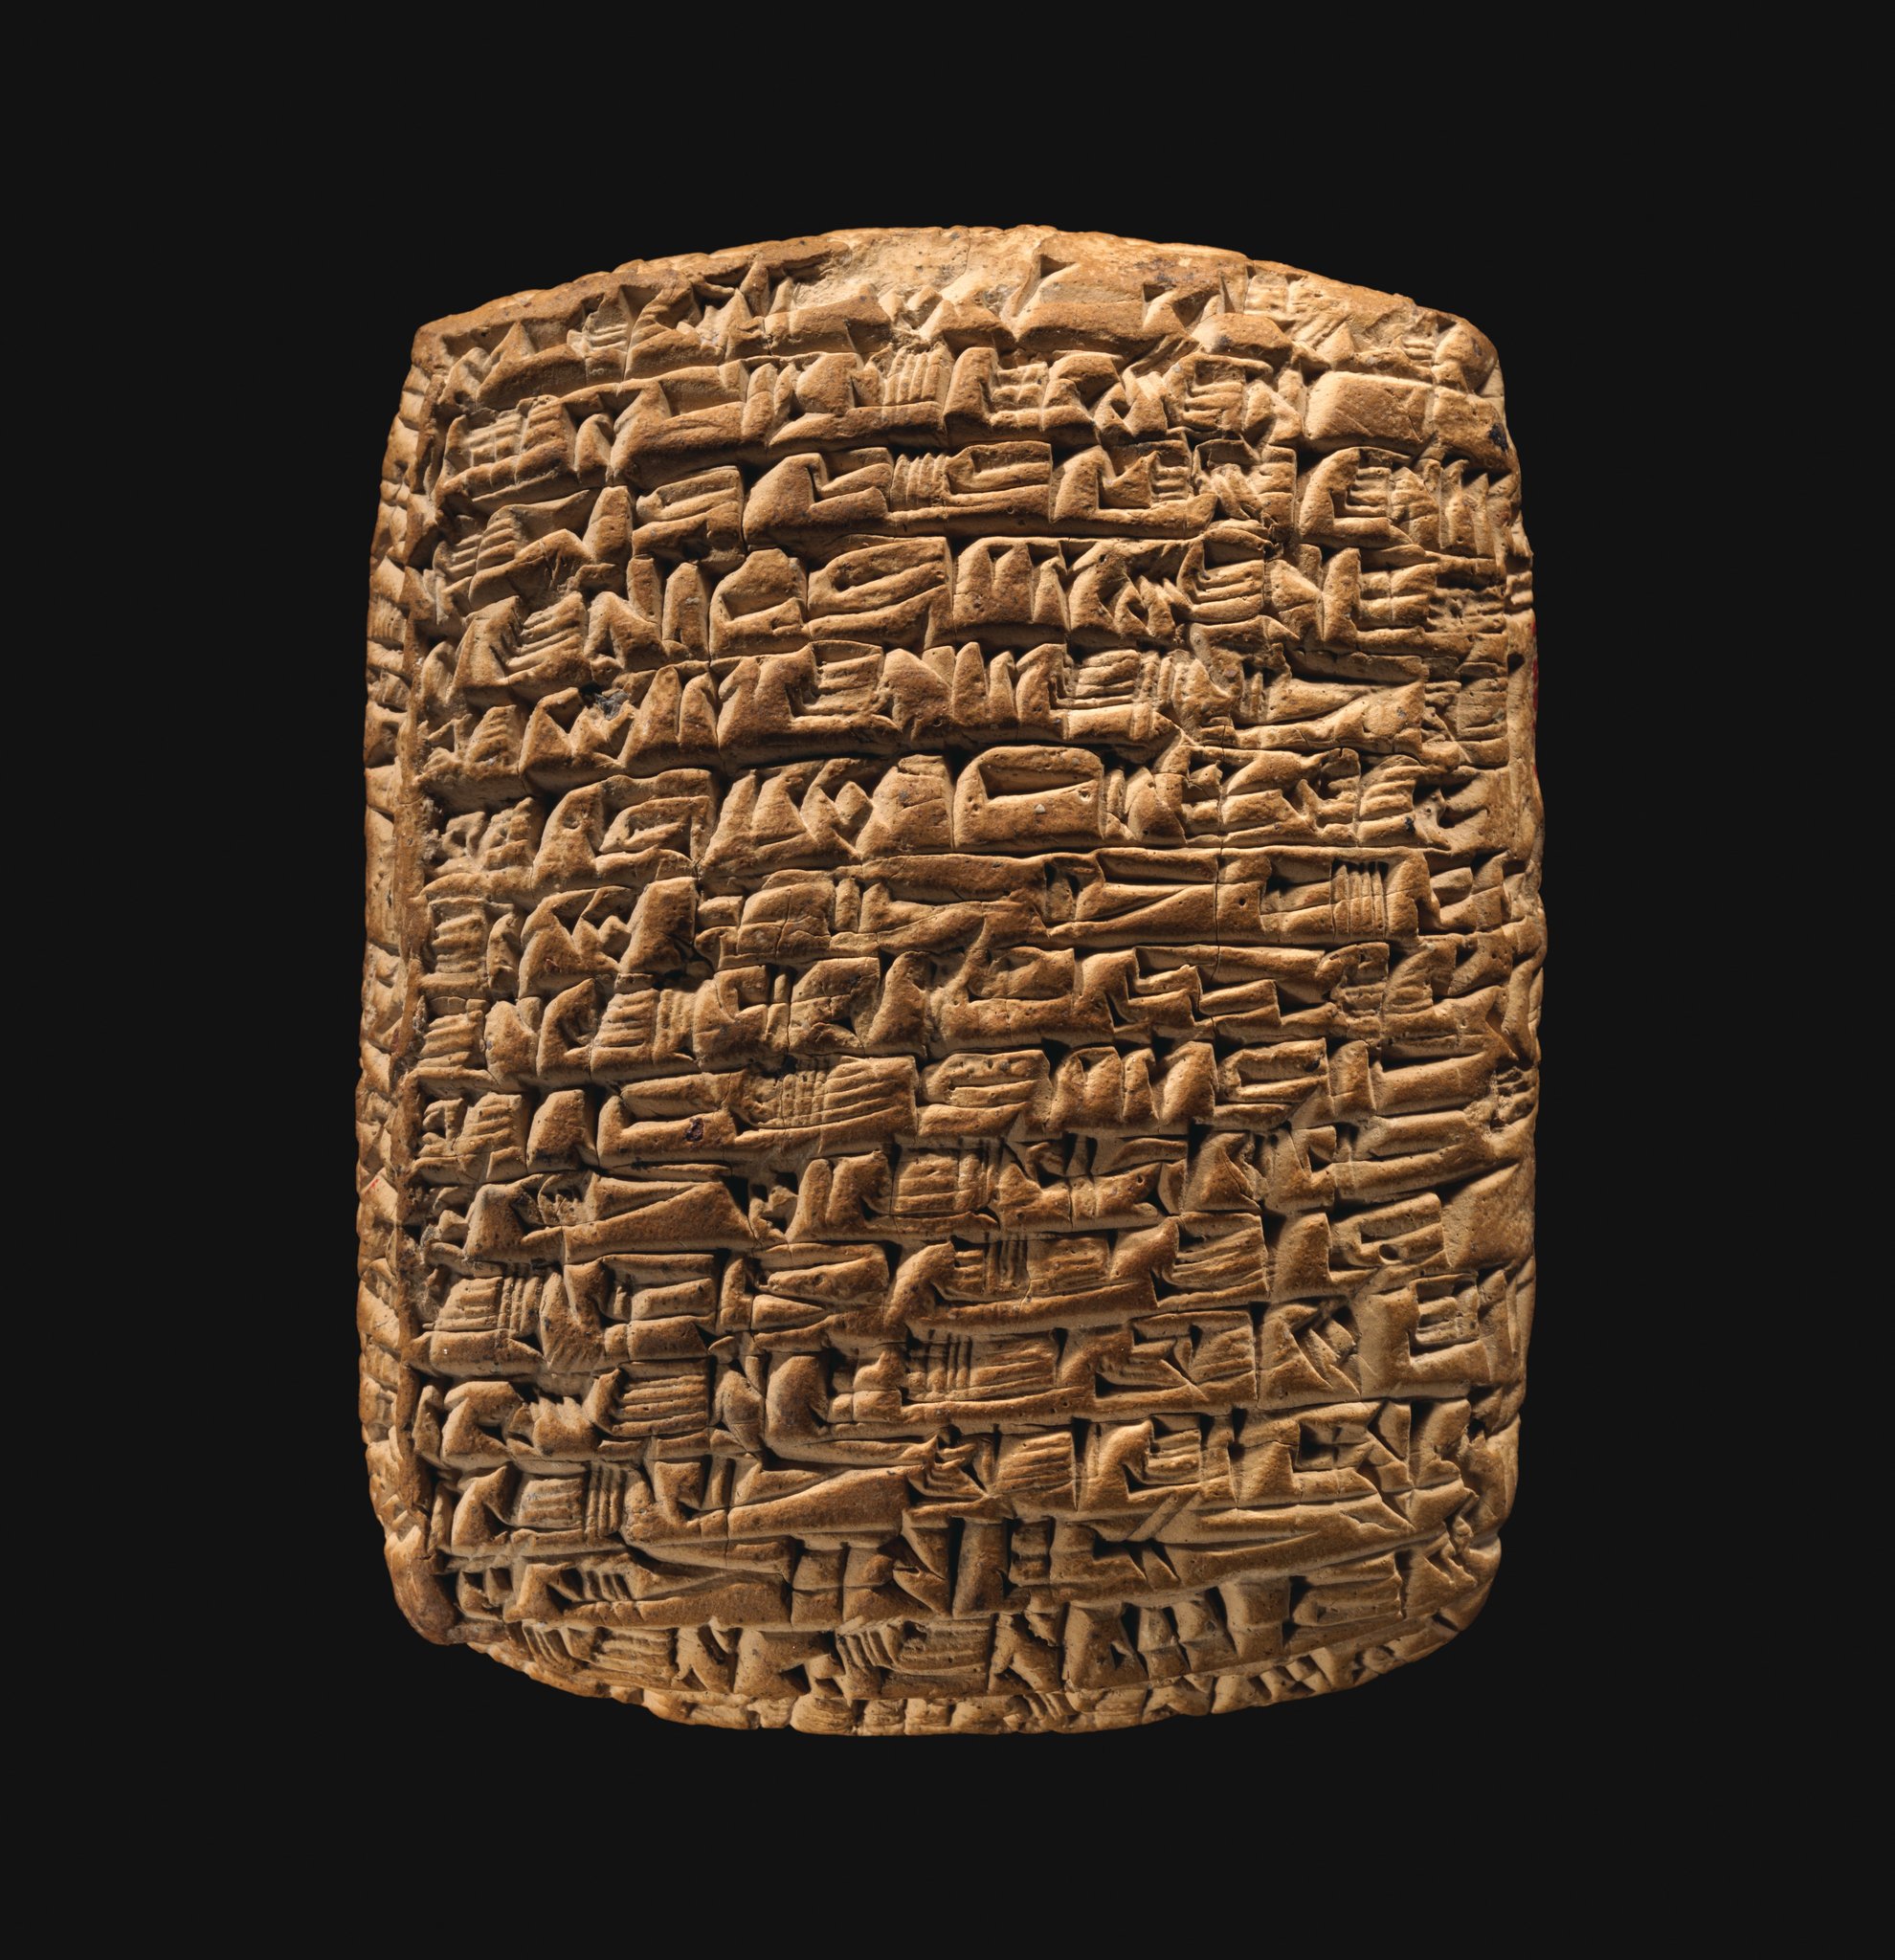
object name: cuneiform tablet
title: Cuneiform tablet: private letter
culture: assyrian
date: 2000-1801 BCE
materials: clay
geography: anatolia